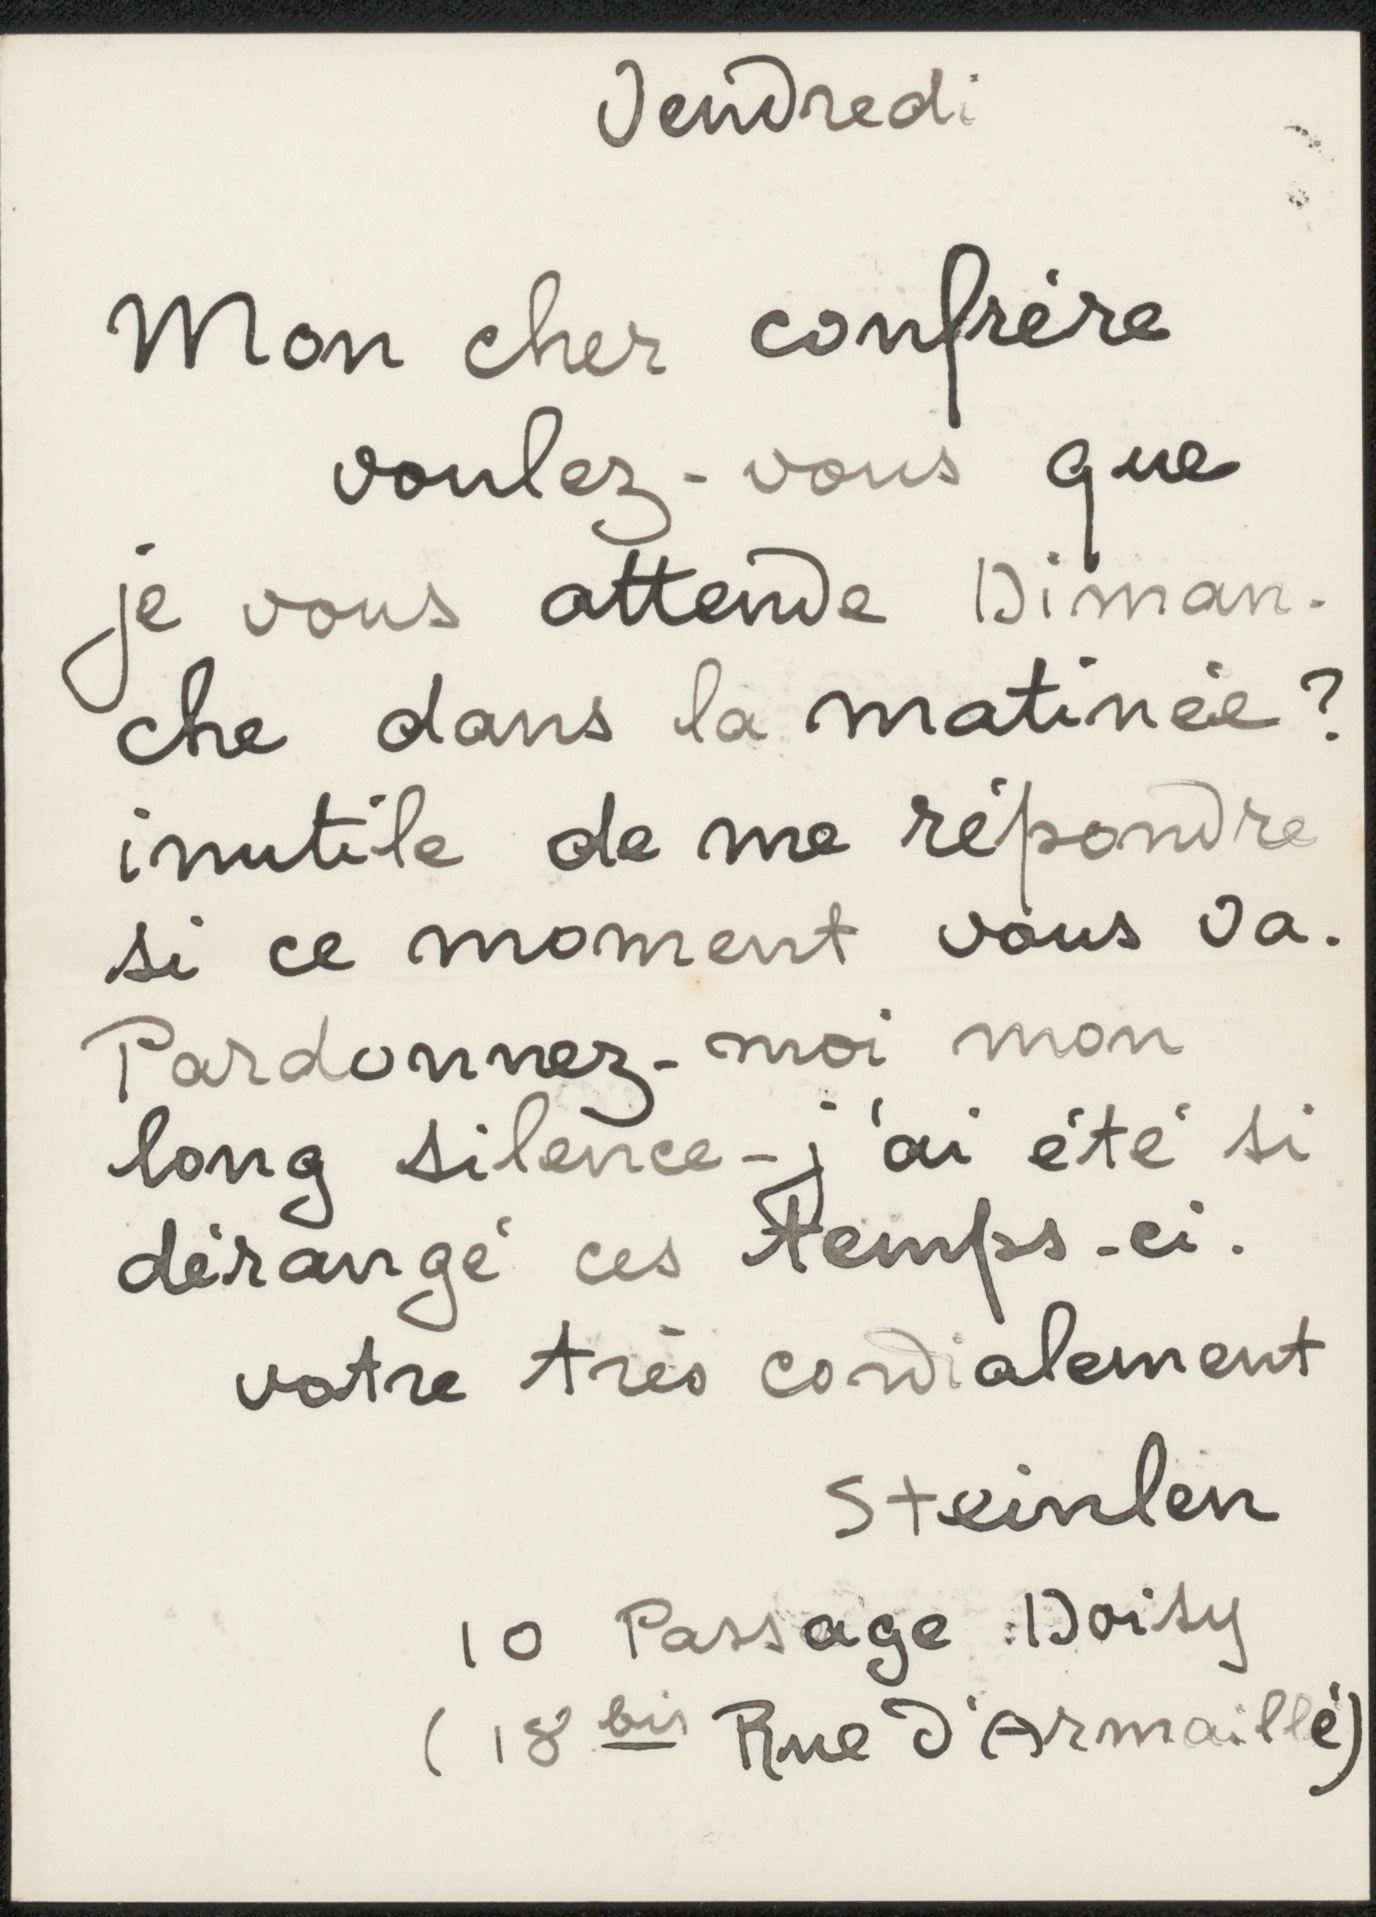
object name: letter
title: Brief aan Philip Zilcken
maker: théophile alexandre steinlen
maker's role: draughtsman, painter, print maker, sculptor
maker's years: 1859-1923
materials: ink, paper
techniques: pen, writing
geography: paris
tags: the hague, philip zilcken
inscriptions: watermark, collector's mark: ‘RPK’